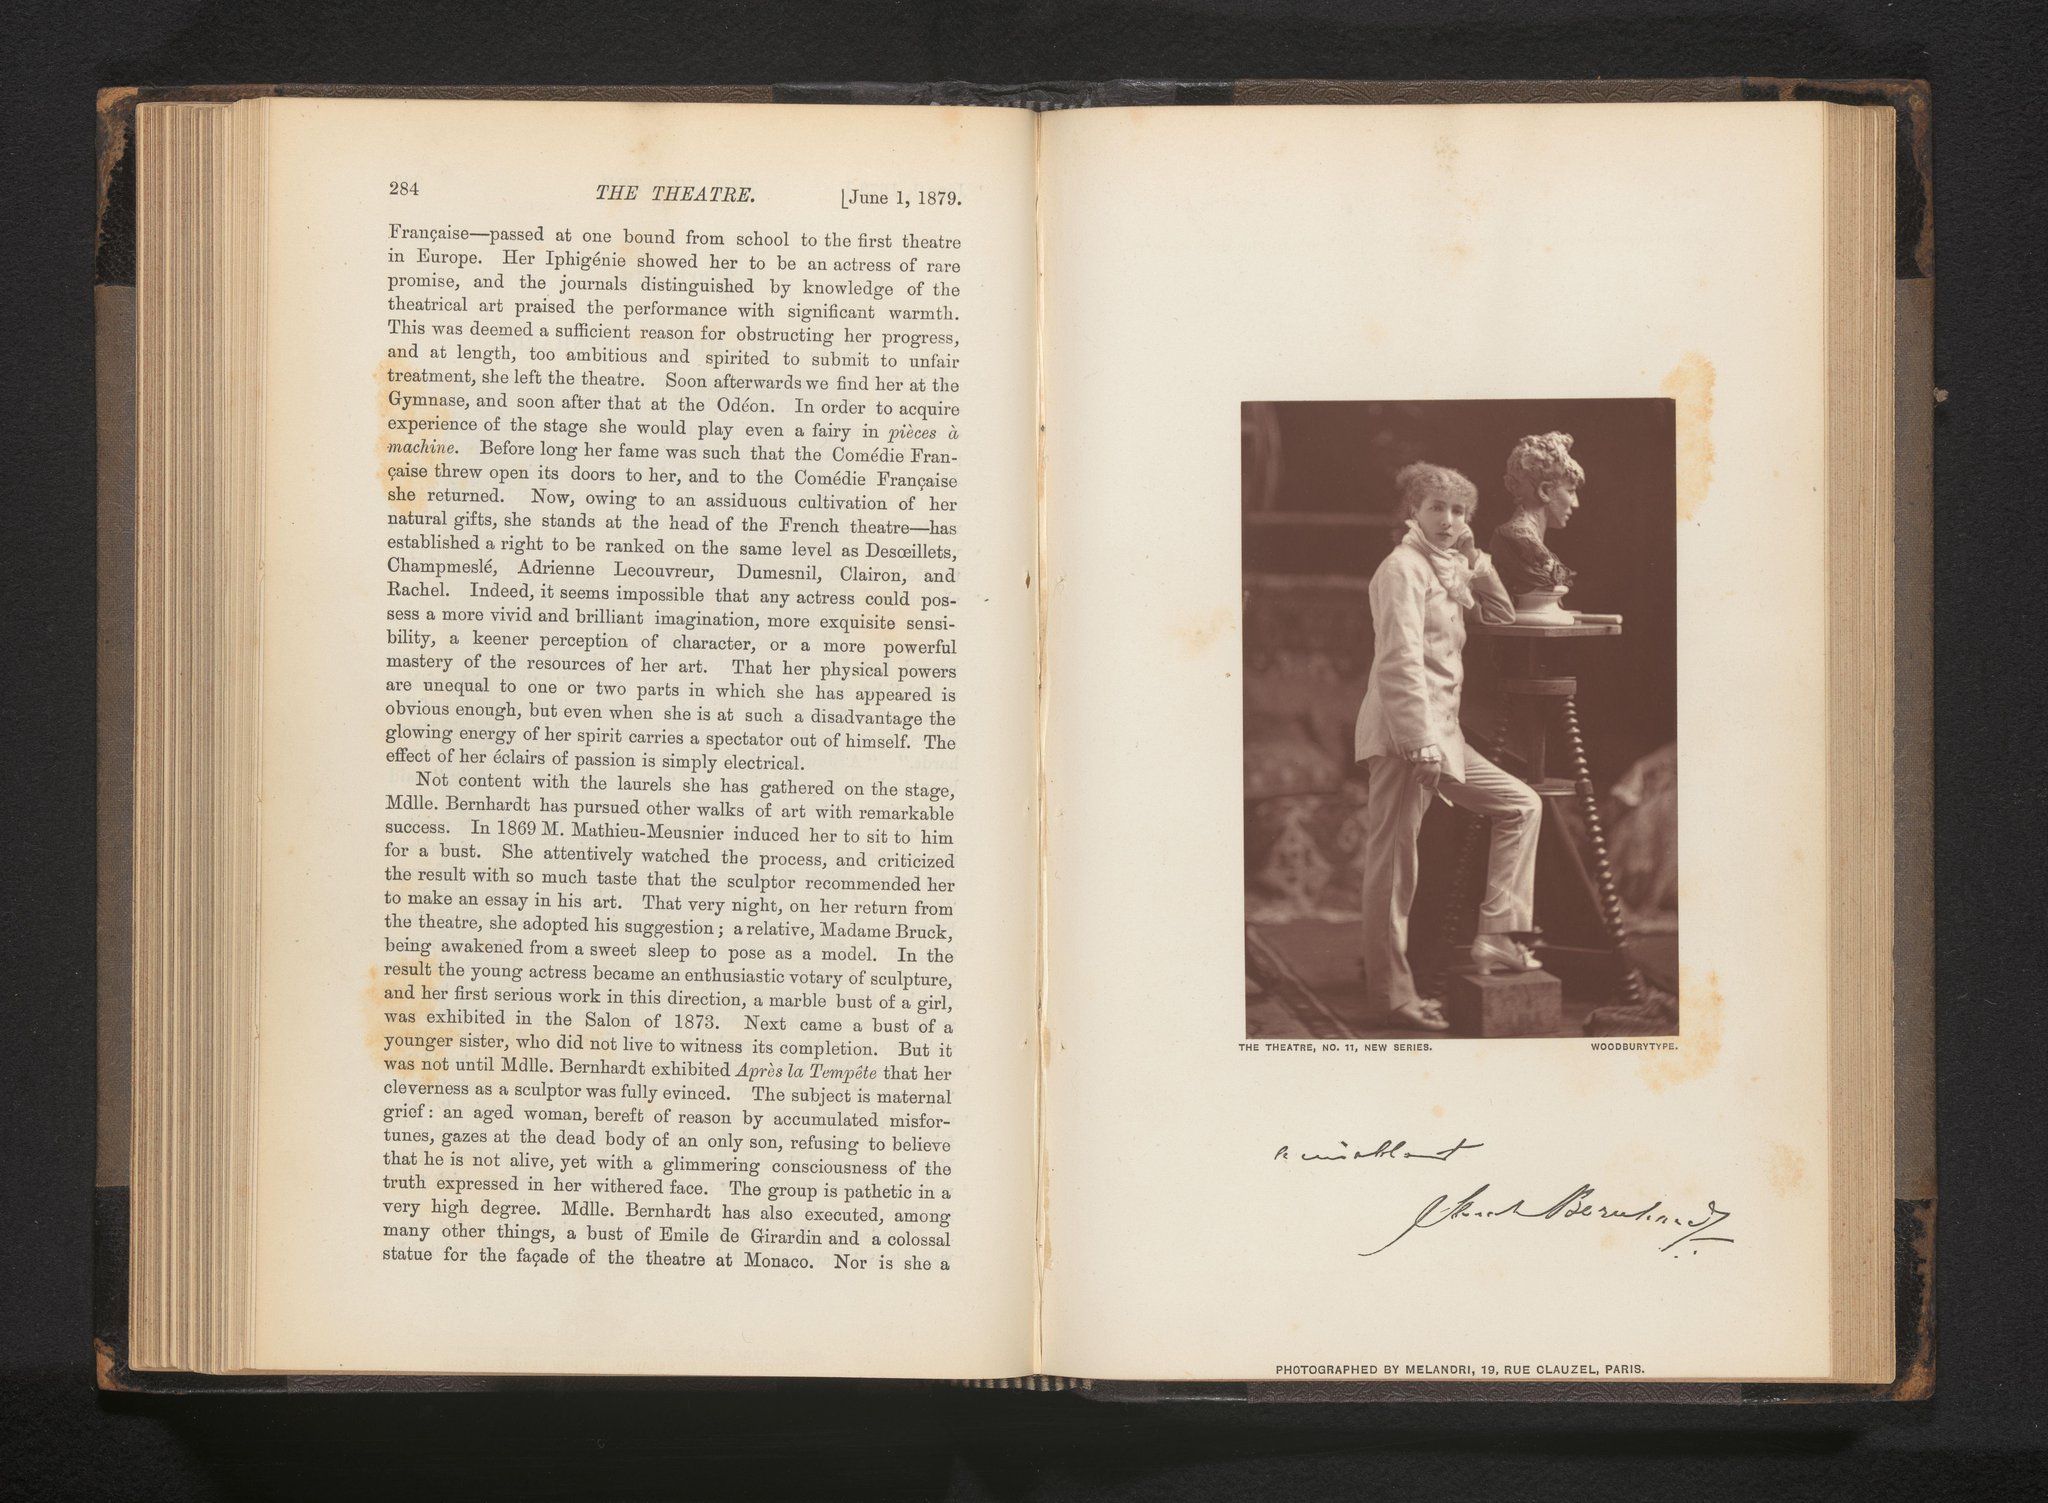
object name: photomechanical print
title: Portret van Sarah Bernhardt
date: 1874-1879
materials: paper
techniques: woodburytype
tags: sculptor, sarah bernhardt, adult woman, historical persons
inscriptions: signature: ‘[...]’